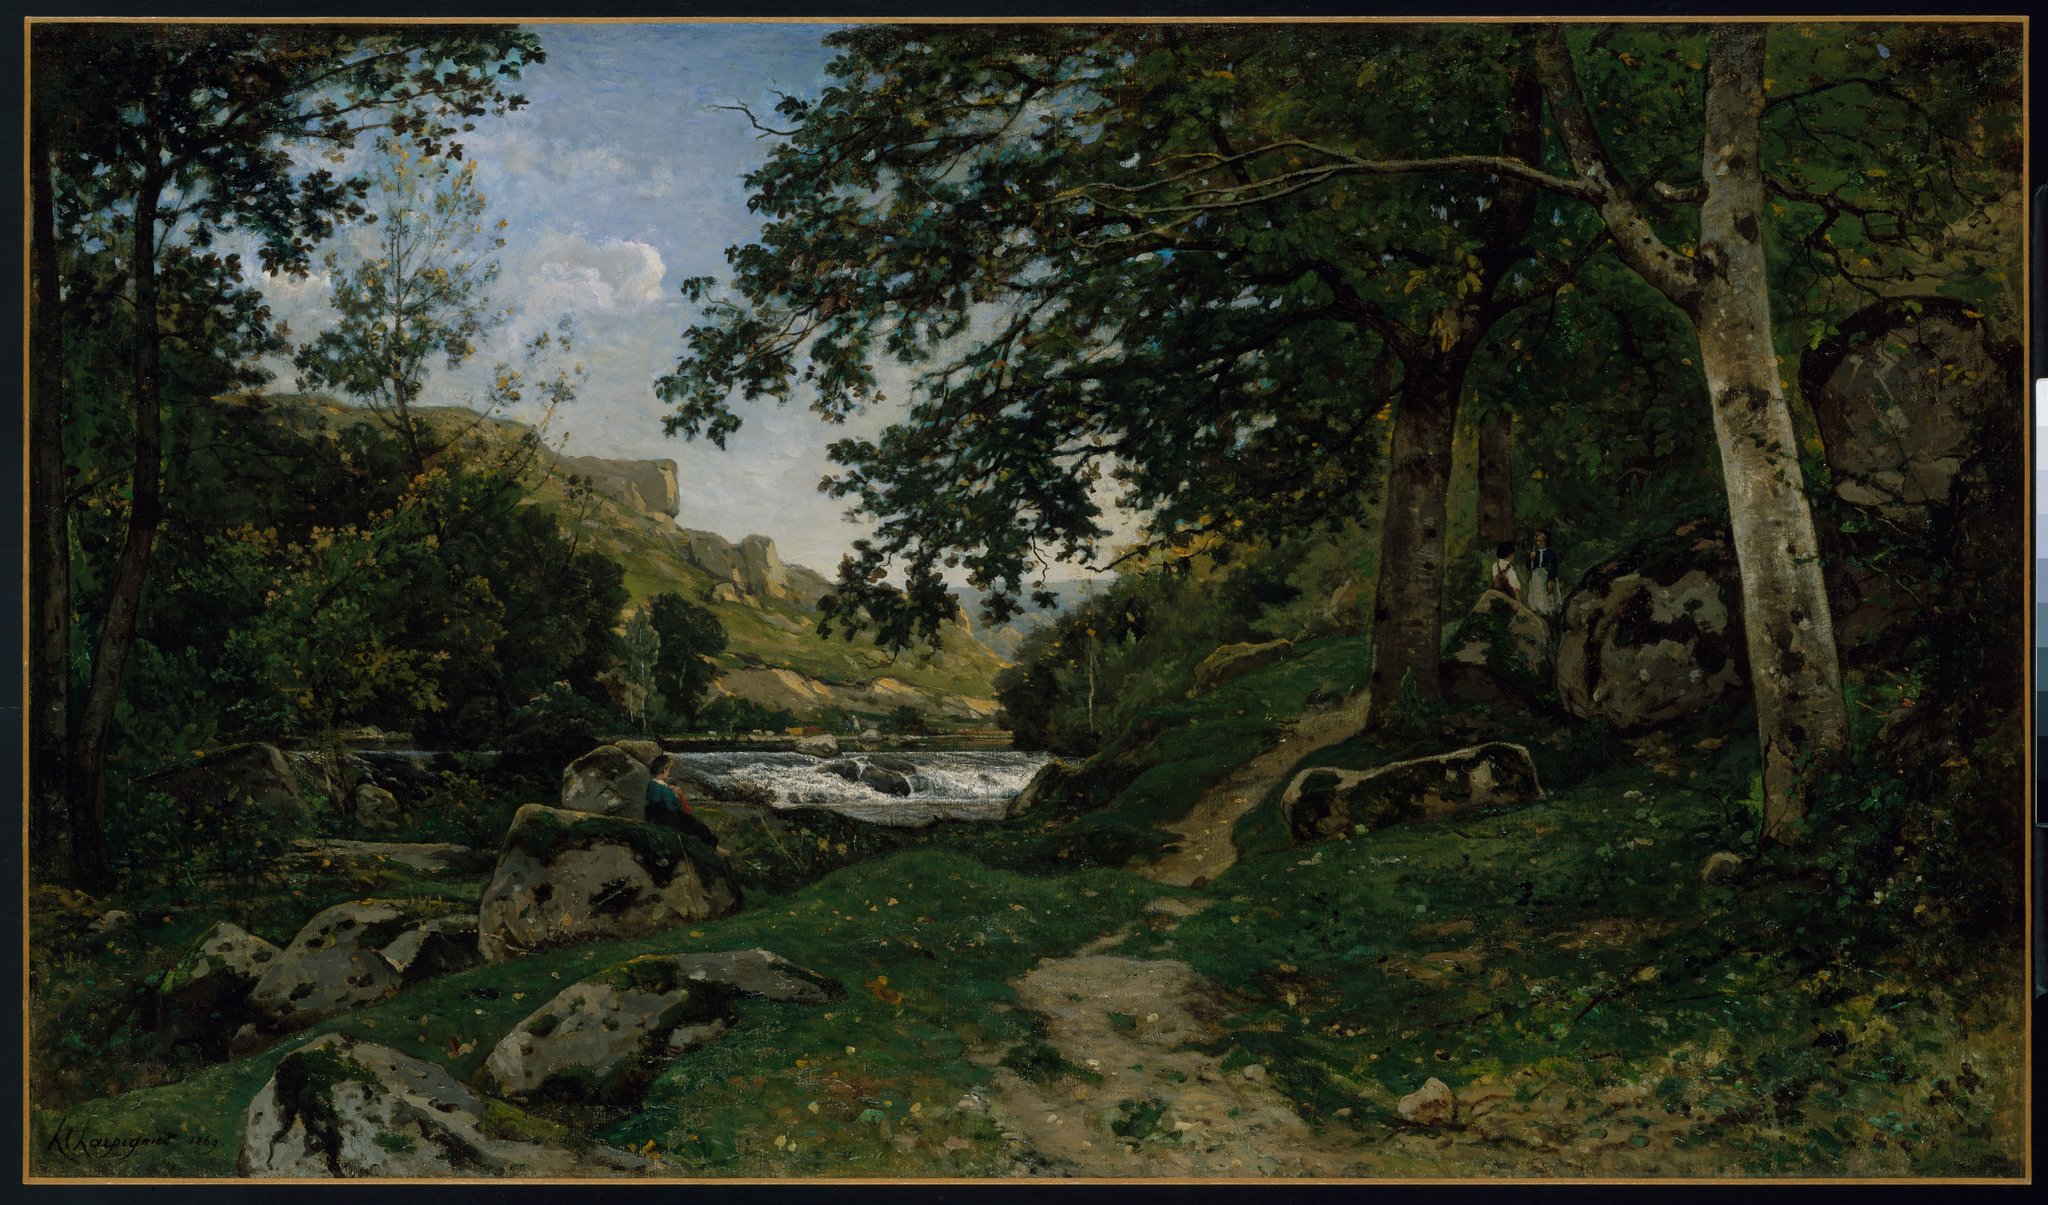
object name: painting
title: The Rocky Path in the Morvan (Chemin des roches dans le Morvan)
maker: henri-joseph harpignies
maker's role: artist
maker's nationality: french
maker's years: 1819-1916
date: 1869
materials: canvas, oil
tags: forests,landscapes